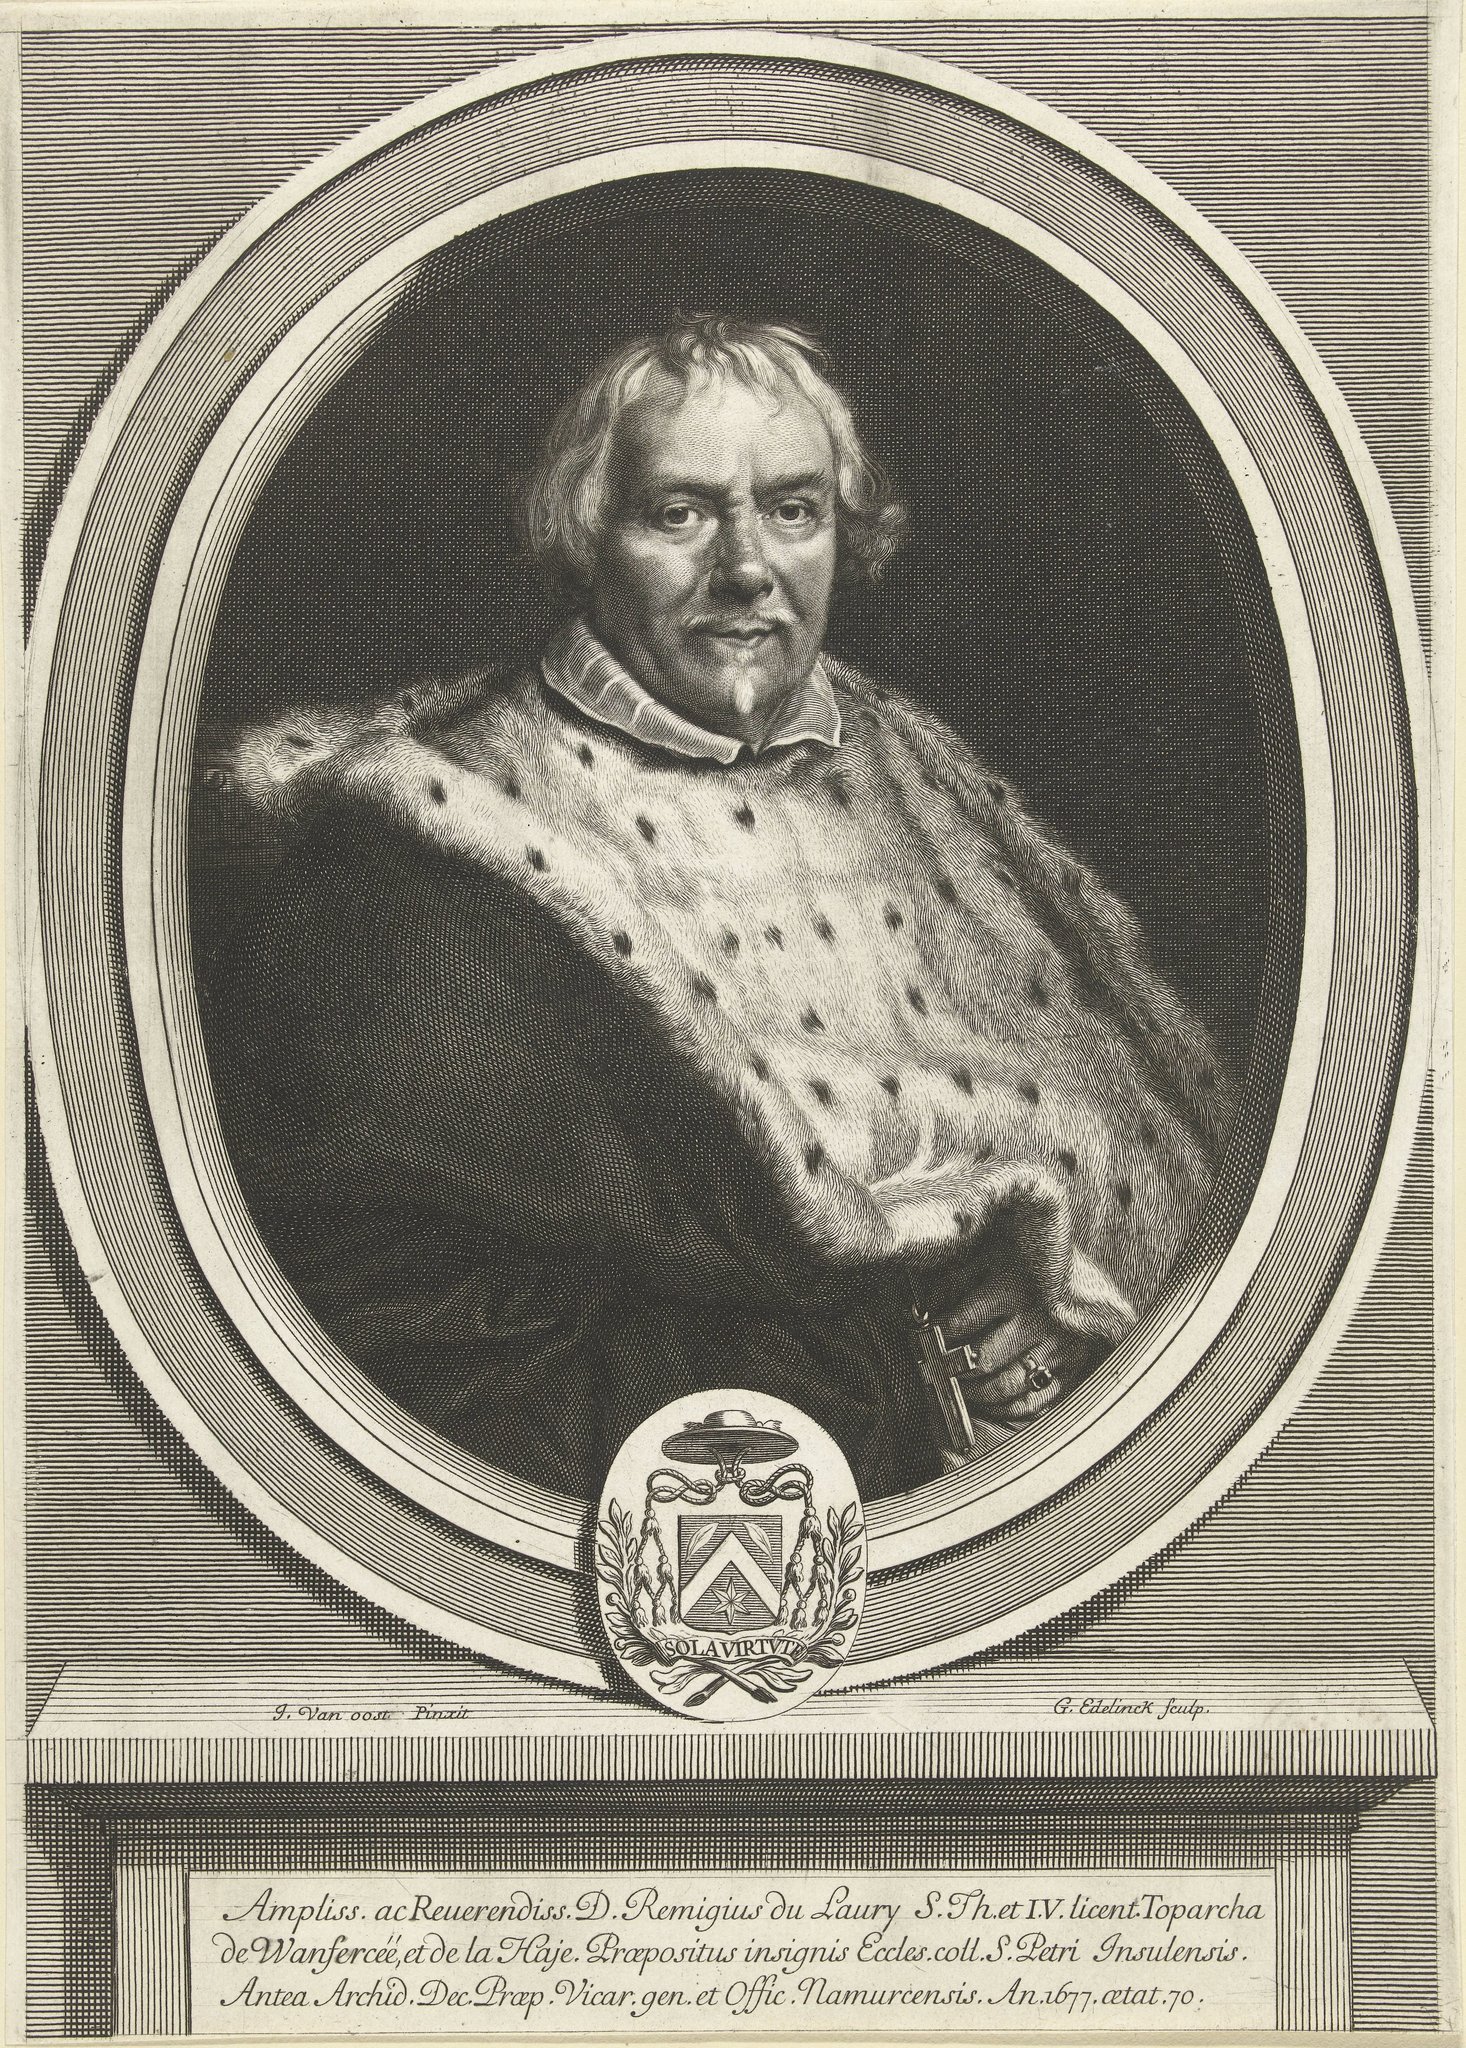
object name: print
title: Portret van Remy du Laury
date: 1676-1707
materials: paper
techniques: engraving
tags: remi du laury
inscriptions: collector's mark: Lugt 240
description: Portret van Remy du Laury, proost van de Sint-Pierre kerk in Lille. Afgebeeld in ovale omlijsting met wapen, waaronder drie regels tekst in Latijn.